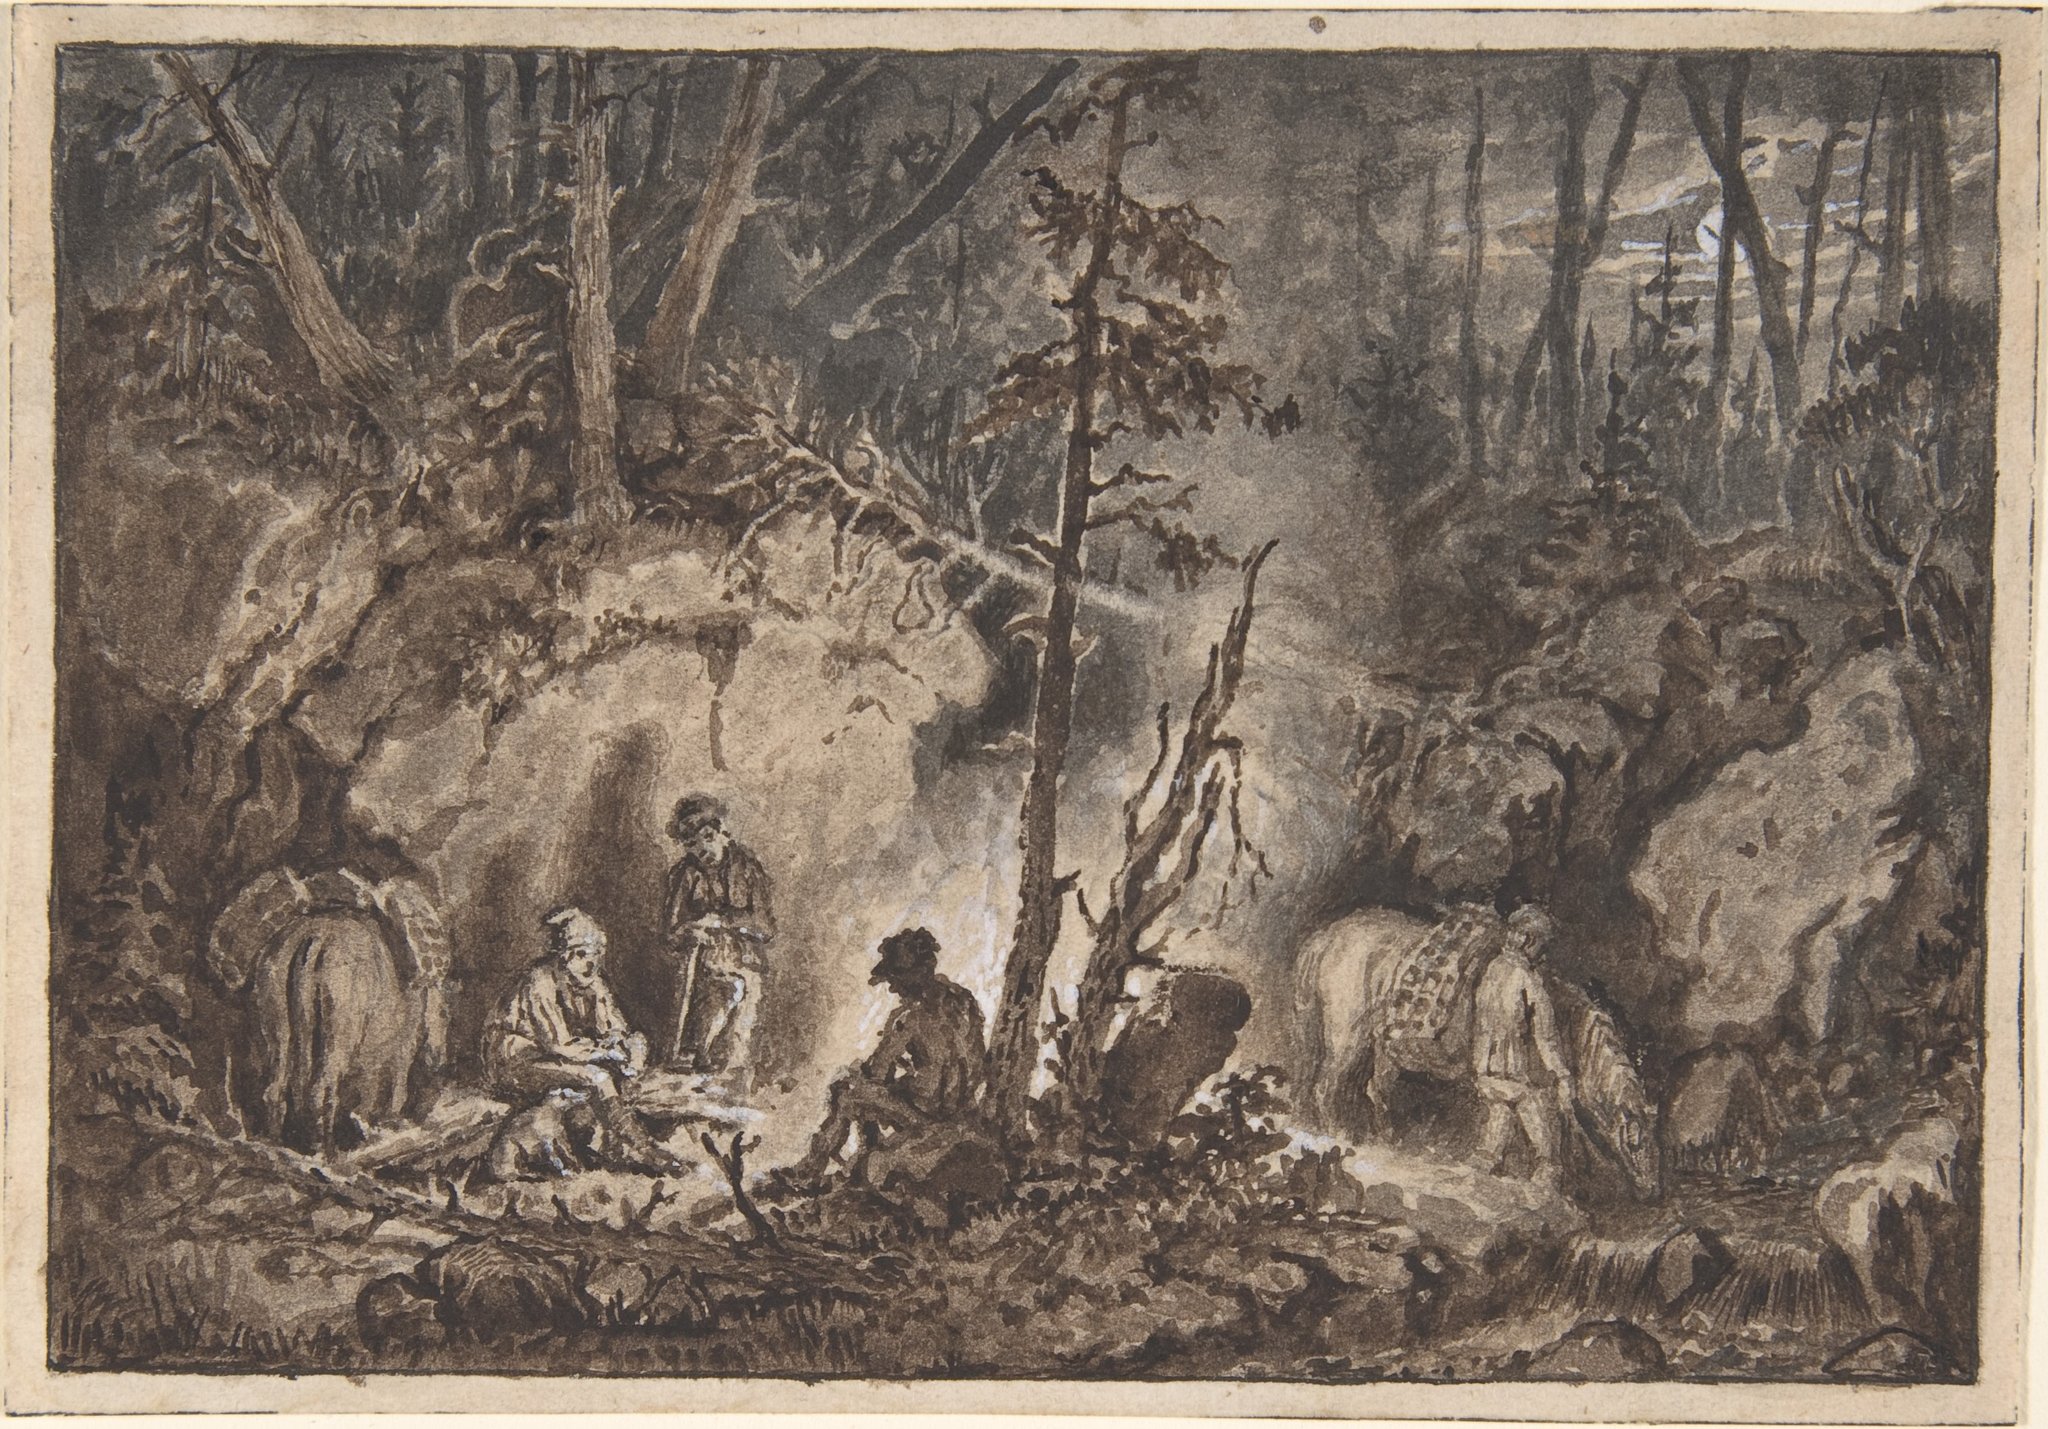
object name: drawing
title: Hunters resting in a forest at night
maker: kilian christoffer zoll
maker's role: artist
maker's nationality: swedish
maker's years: 1818-1860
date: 1830-1860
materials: ink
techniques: brush, heightening, pen, wash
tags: animals,men,fire,forests,night